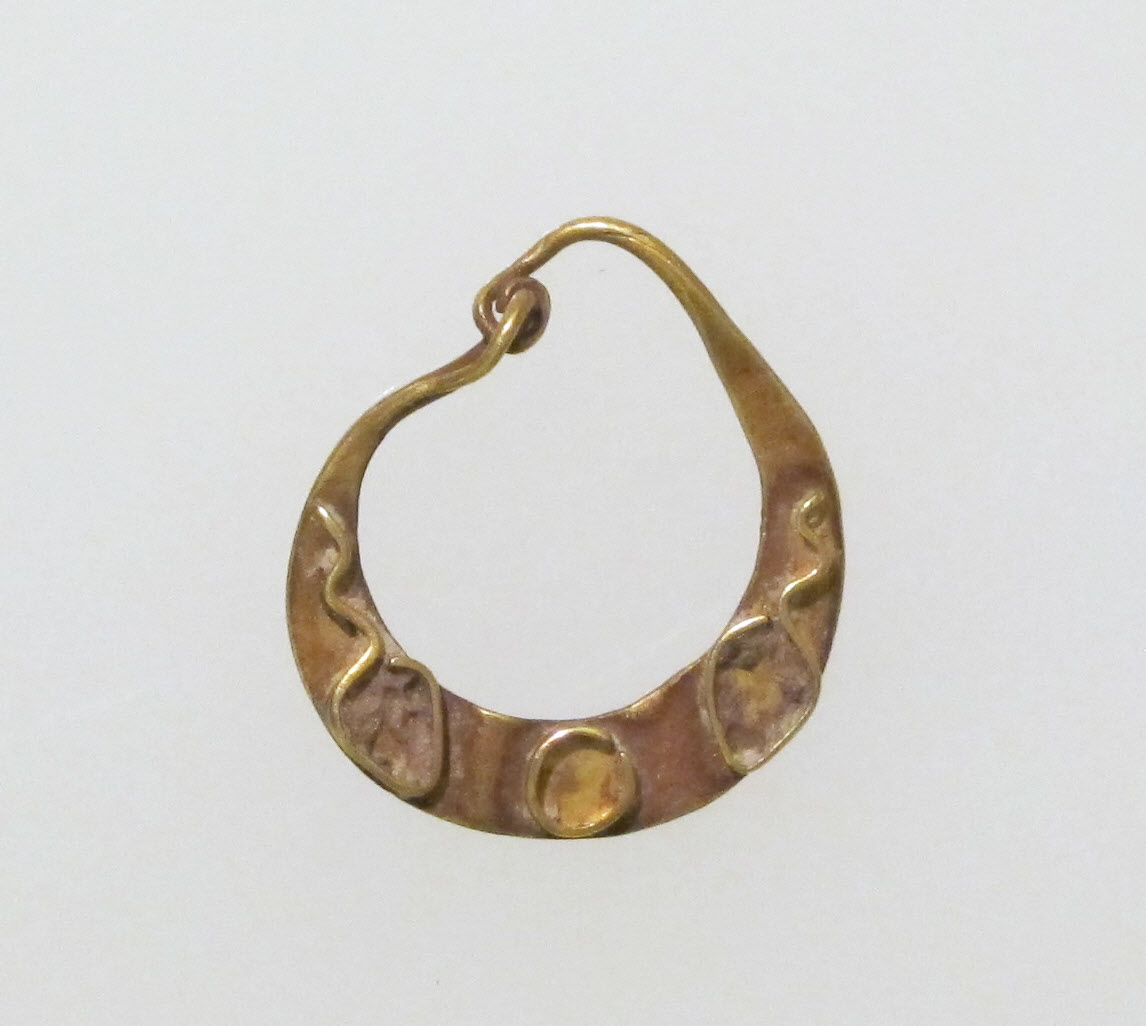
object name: earring, crescent shaped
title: Earring, crescent-shaped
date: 7000 BCE-330 CE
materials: gold